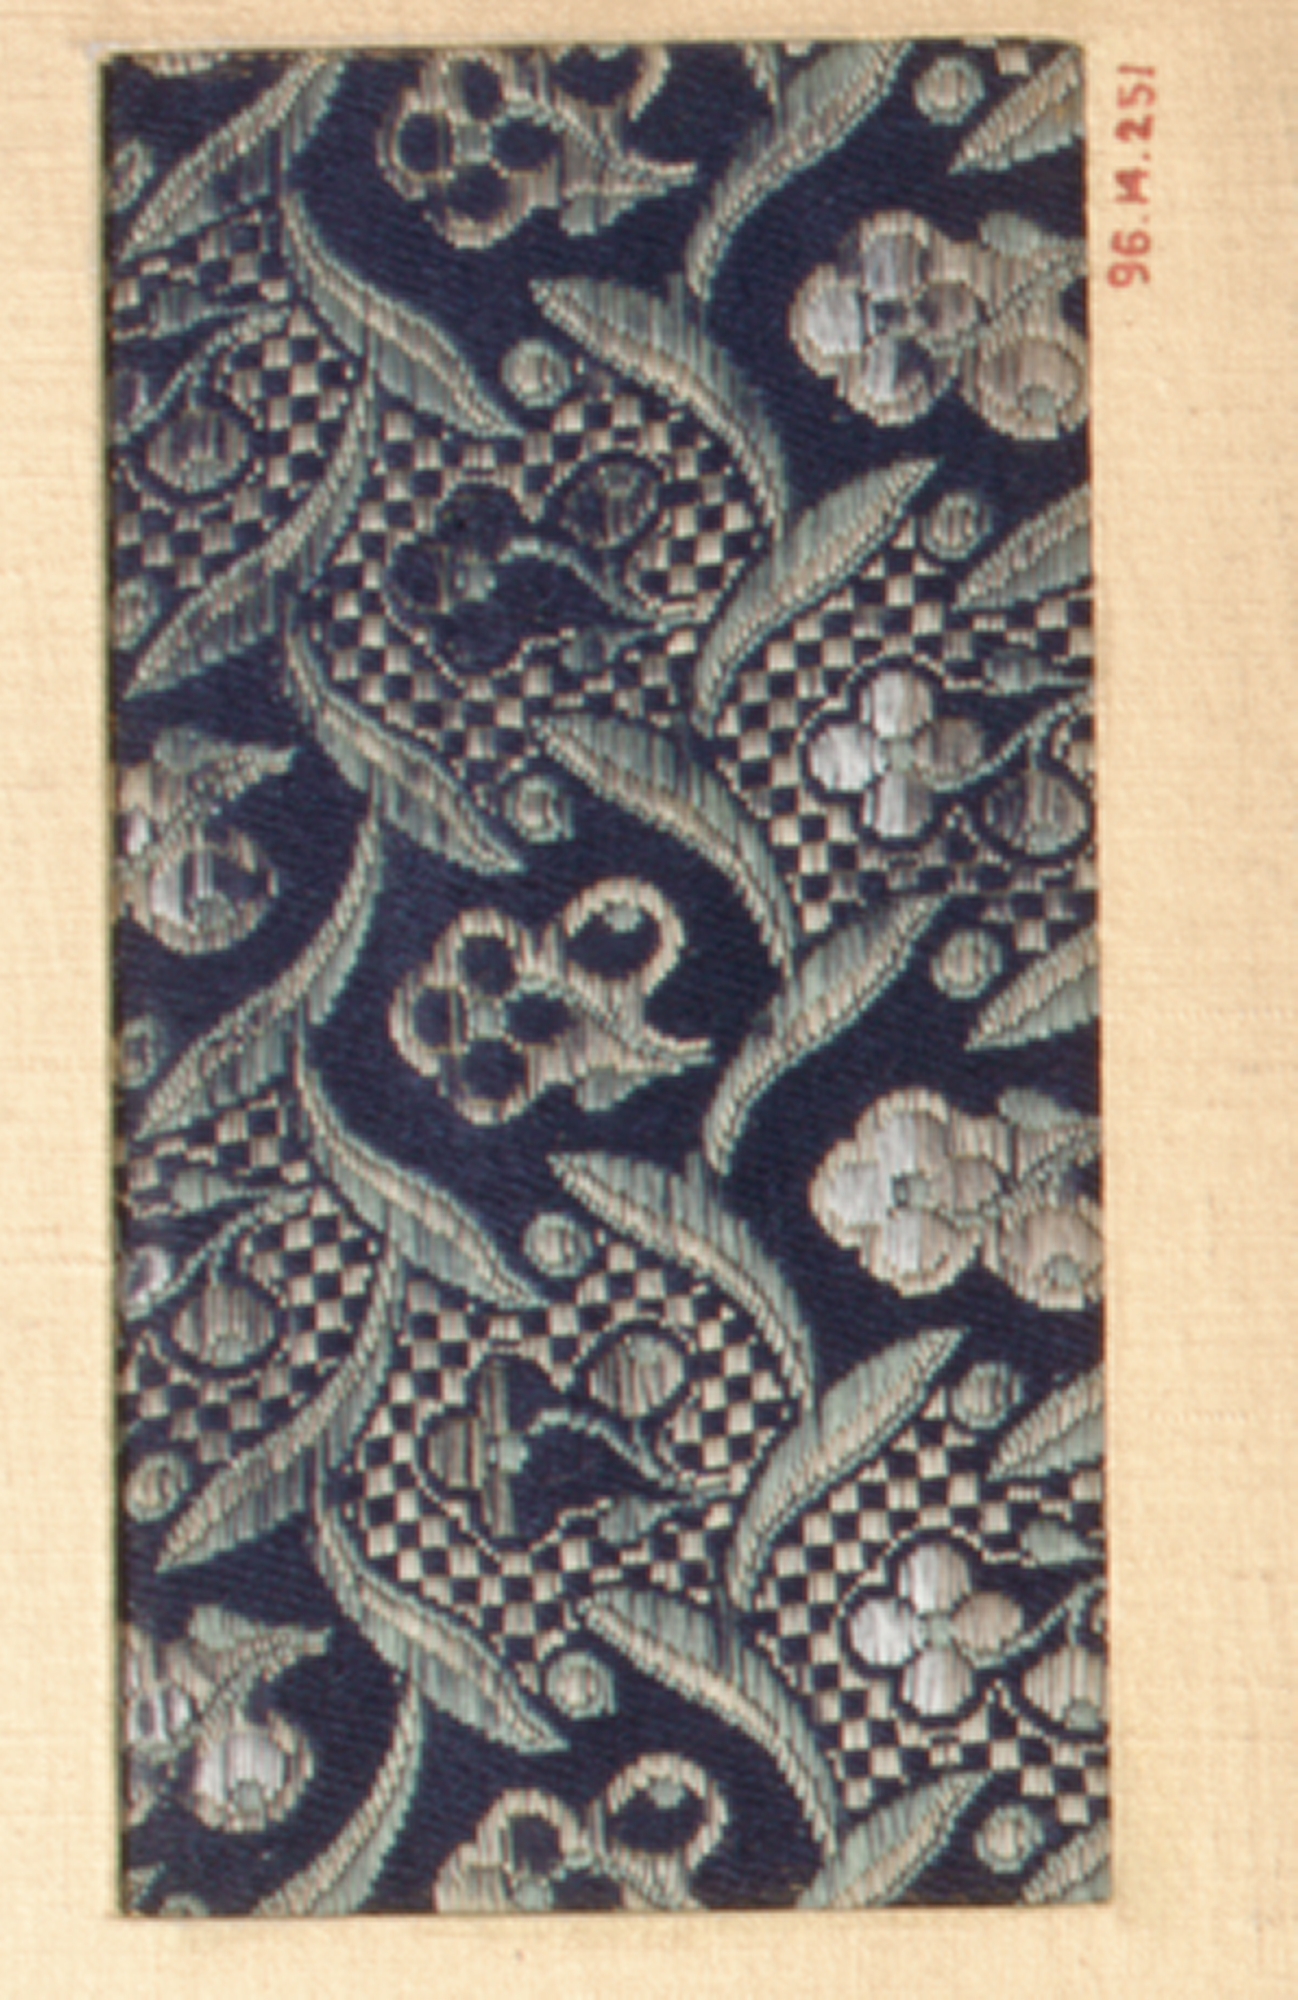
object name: piece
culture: japanese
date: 1701-1900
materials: silk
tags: leaves